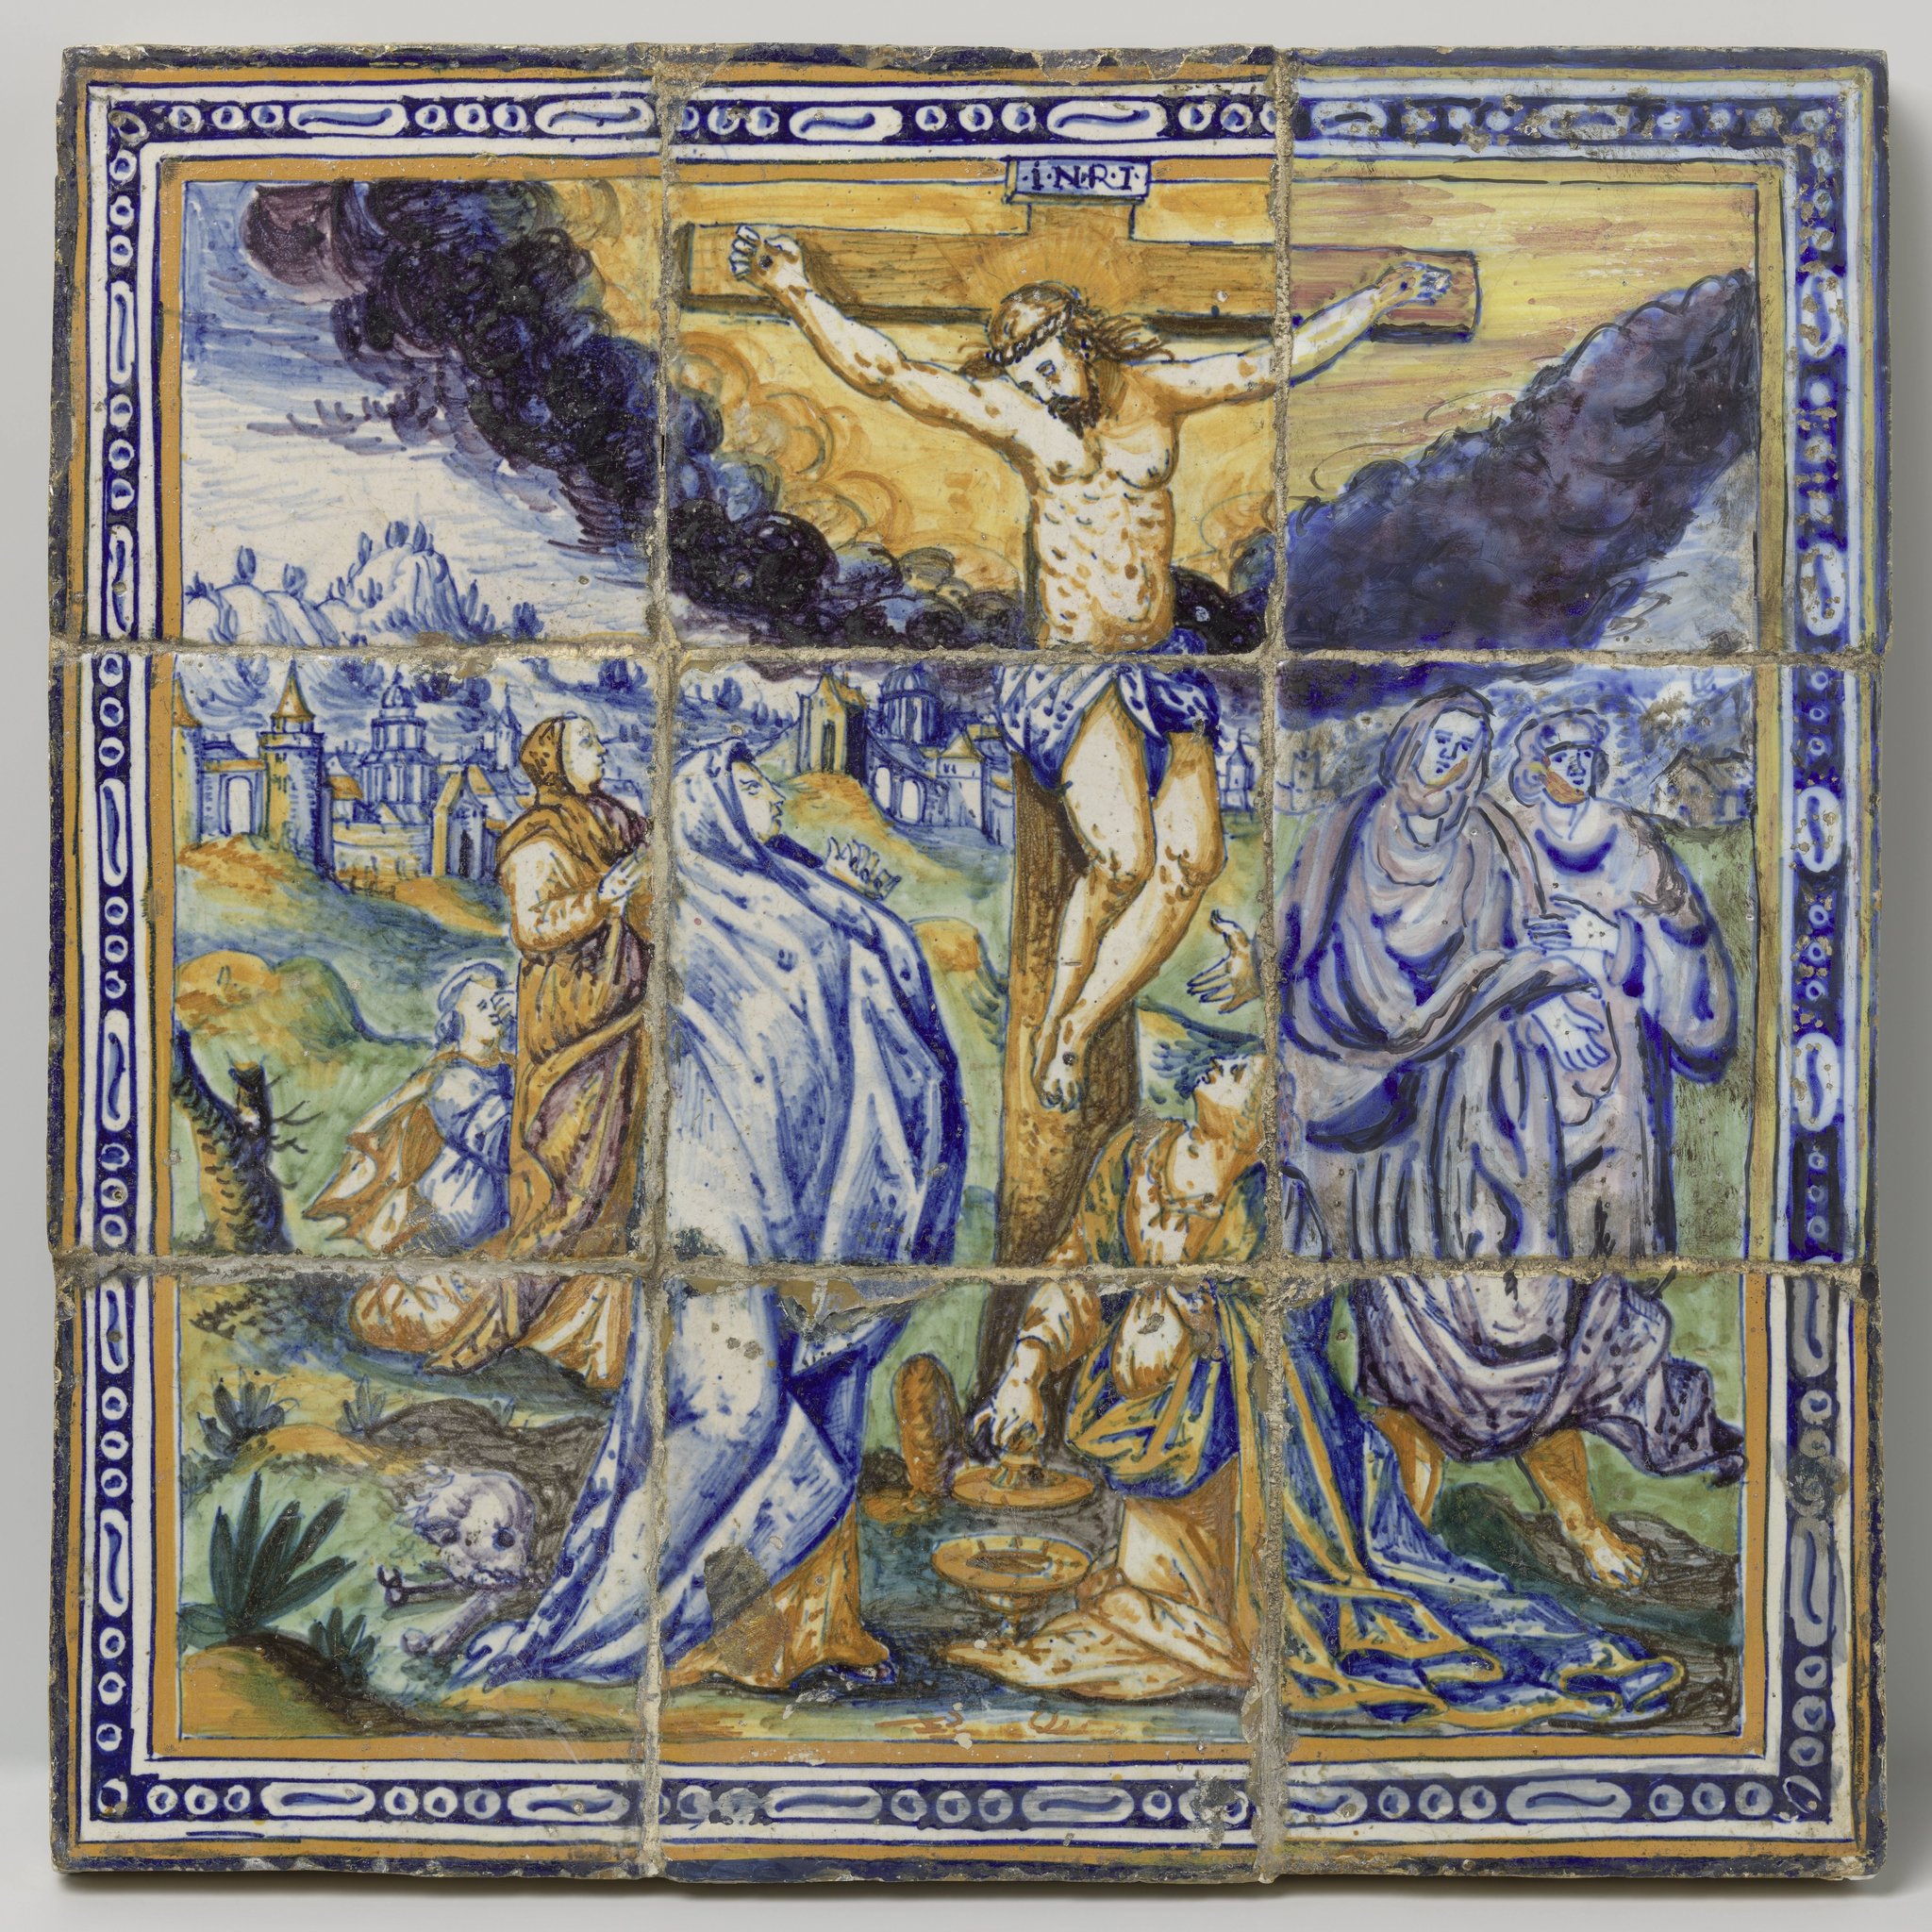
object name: tile tableau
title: Tegeltableau met de Kruisiging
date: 1600-1620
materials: earthenware, glaze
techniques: maiolica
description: Tegeltableau van negen tegels (3 x 3) met een veelkleurige (blauw, groen, bruin, oranje en paars) bijbelse voorstelling van Christus aan het kruis in een landschap met gebouwen op de achtergrond. Rond de voorstelling, een parellijst.